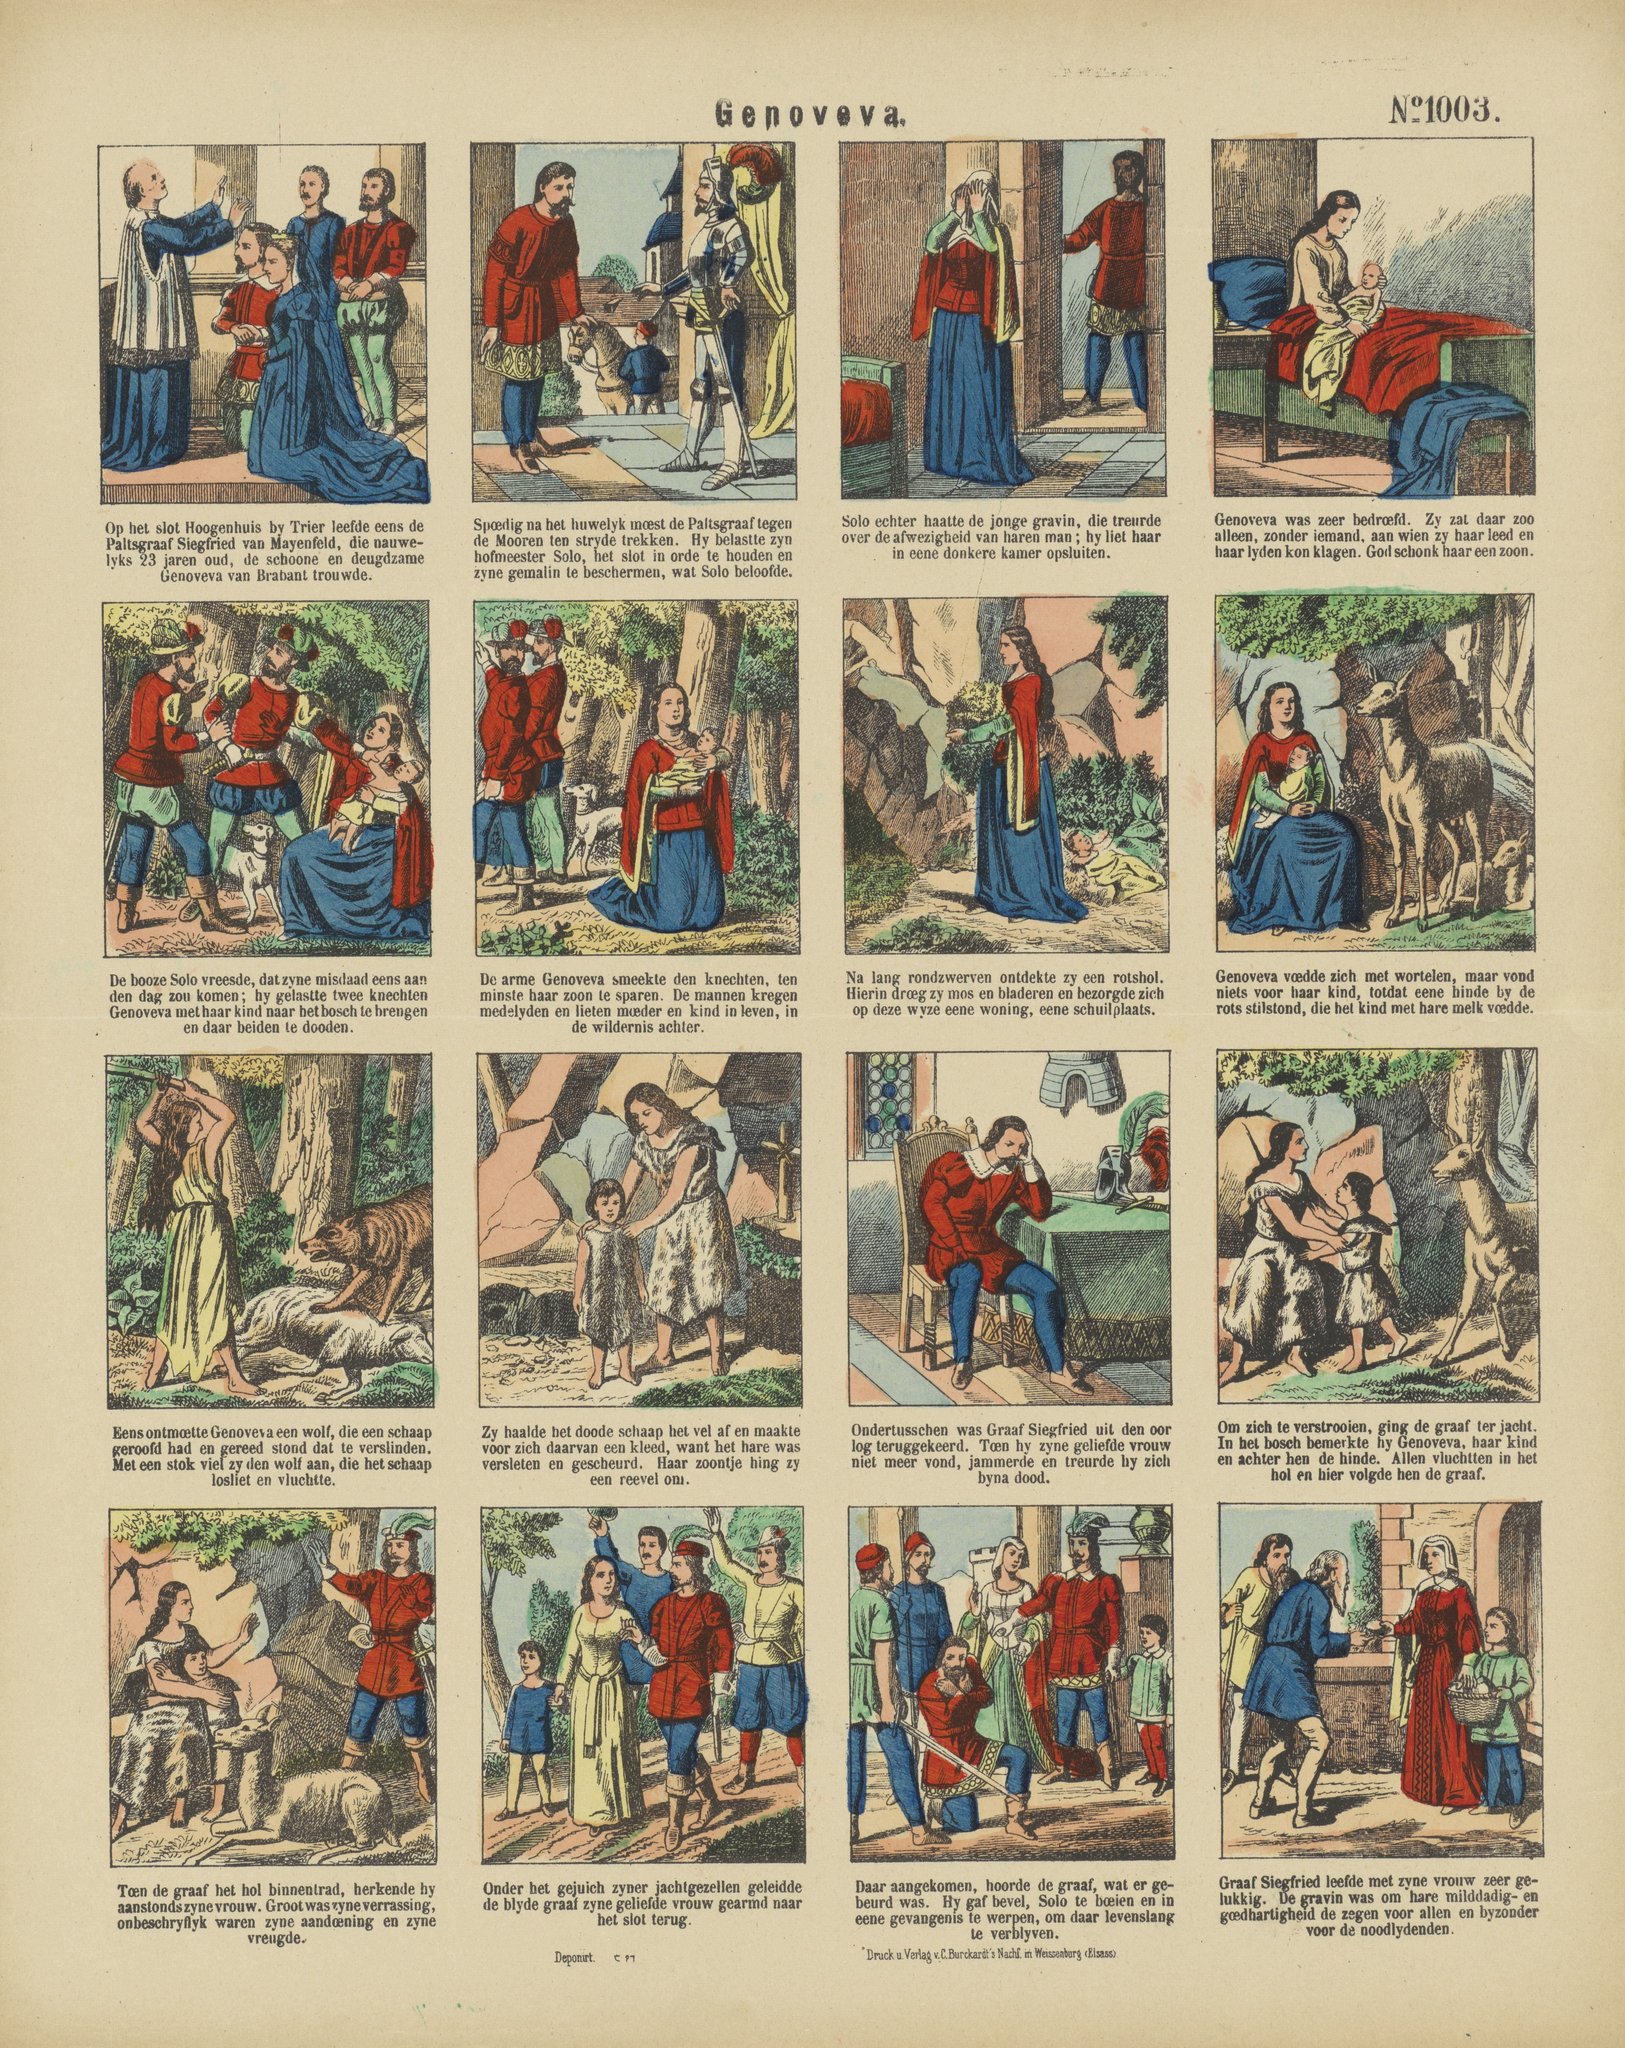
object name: popular print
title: Genoveva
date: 1889-1906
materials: paper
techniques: hand coloring, letterpress printing, lithograph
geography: wissembourg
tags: genoveva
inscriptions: collector's mark: Lugt 2760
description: Blad met 16 voorstellingen uit het verhaal van Genoveva van Brabant. Onder elke afbeelding een onderschrift. Genummerd rechtsboven: No. 1003.